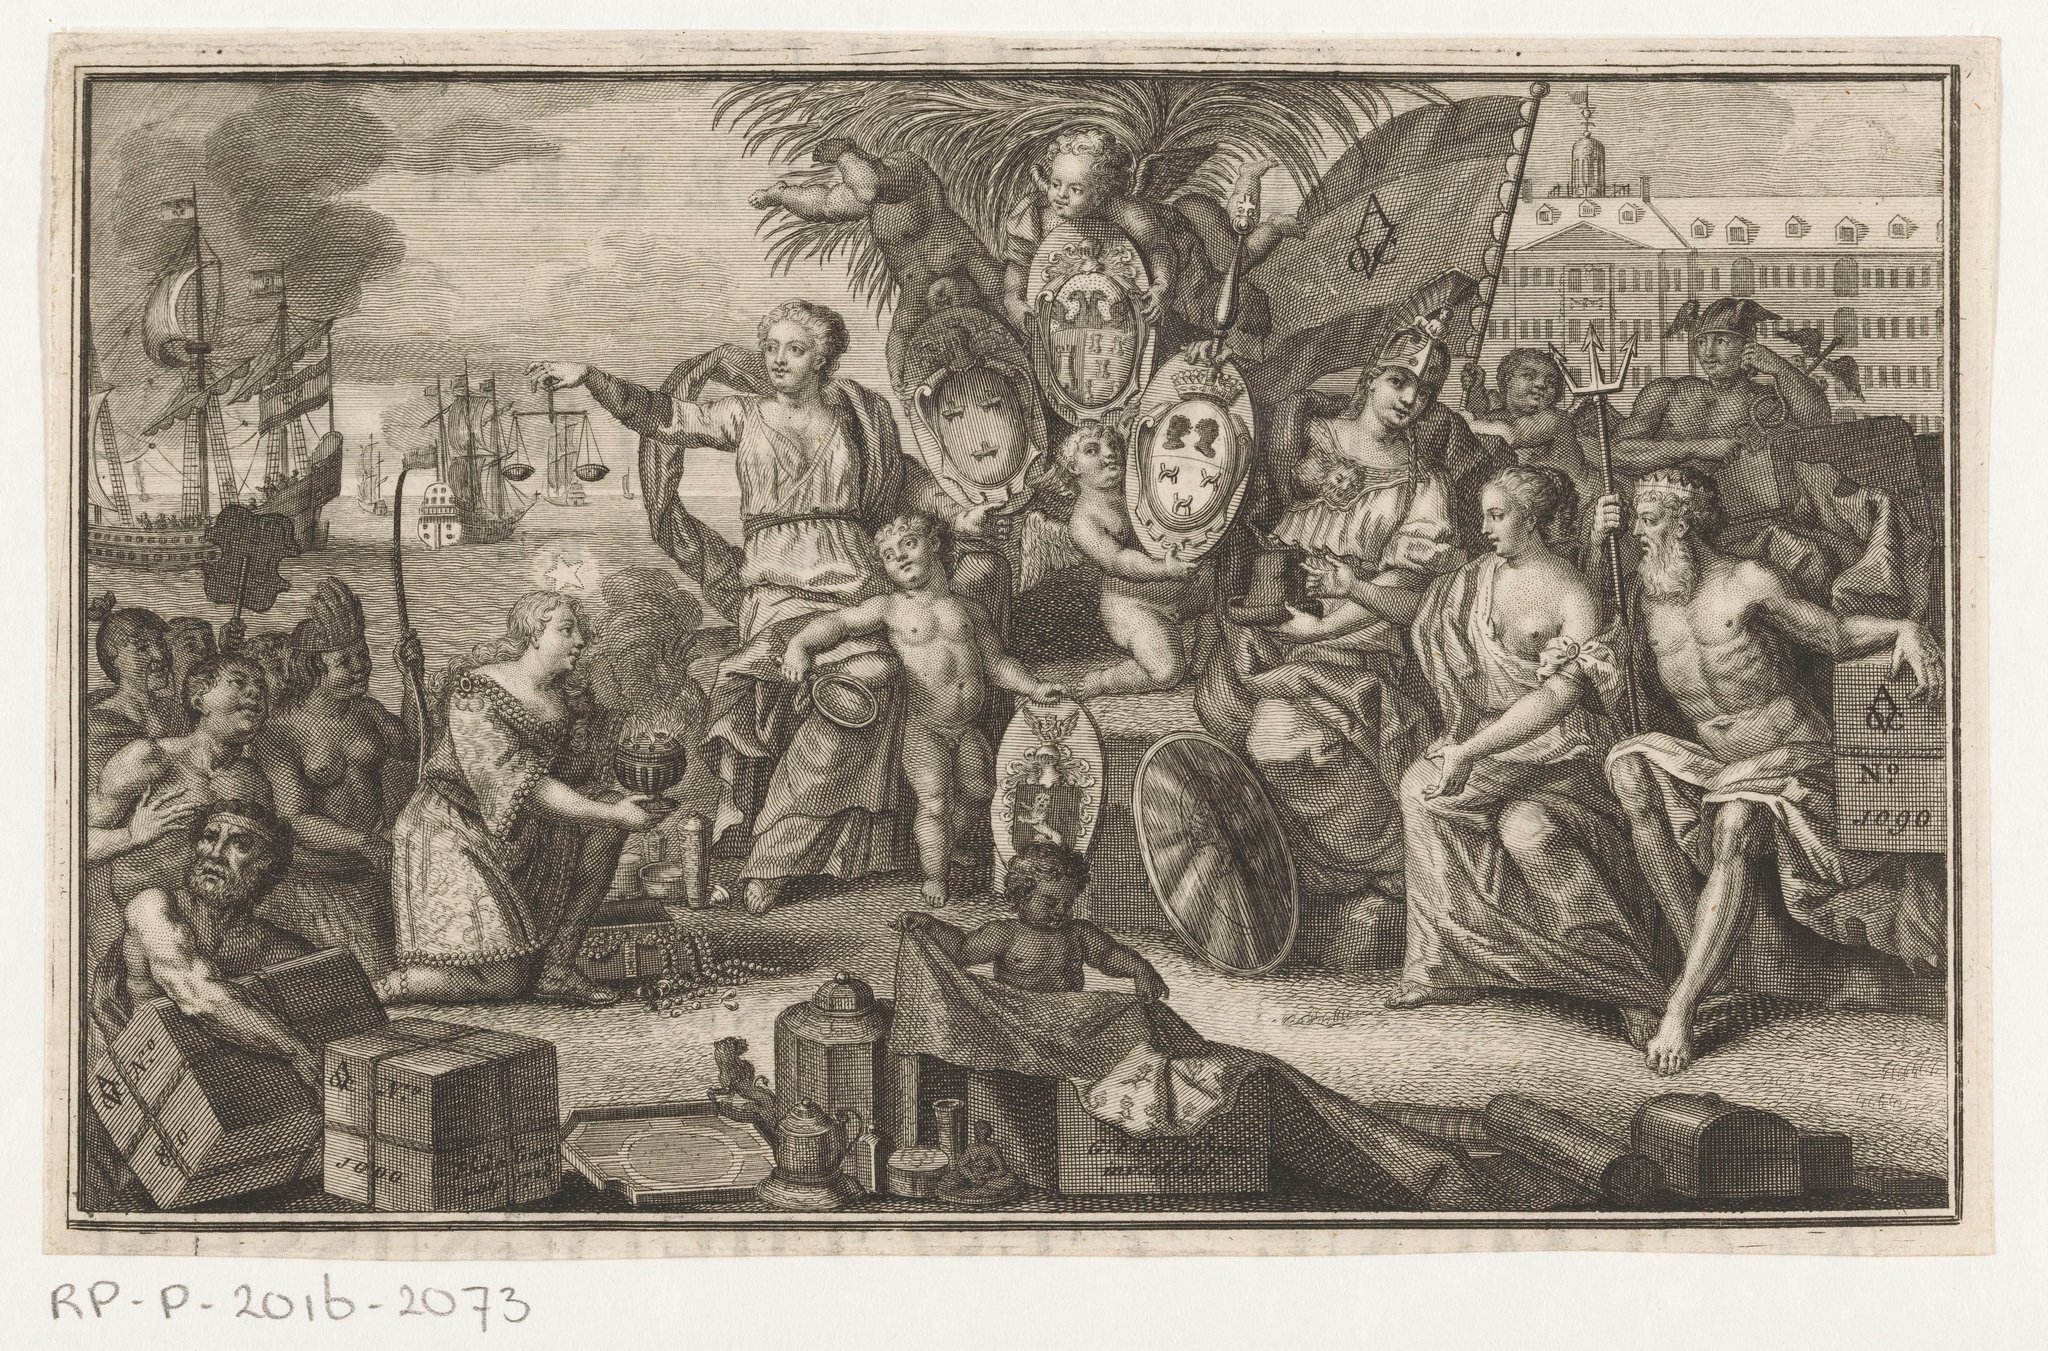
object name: book illustration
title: Allegorie op de Oost-Indische Compagnie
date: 1728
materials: paper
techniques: etching, letterpress printing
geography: amsterdam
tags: dordrecht, mayor, asiatic races and peoples, trade-company, justice, 'justitia'; 'giustitia divina' (ripa) ~ one of the four cardinal virtues, (story of) minerva (pallas, athena)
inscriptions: collector's mark: Lugt 2228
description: Putti met wapenschilden van Aegidius van den Bempden, Hendrik Trip, Adriaan van Loon en Reinier Bouwens (burgemeester en bewindhebbers van de handelscompagnie) worden geflankeerd door Rechtvaardigheid met weegschaal en Minerva met (vrijheids)hoed in de hand. Rechts een putto met vlag van de VOC, Mercurius als handelsgod, Neptunus als god van de zee, een allegorische vrouwenfiguur en het Oostindisch-magazijn te Amsterdam. Links handelsschepen op zee, mensen die de Oost-Indische volkeren vertegenwoordigen en een vrouw met wierookvat en ster op het hoofd. Op de voorgrond handelswaar.